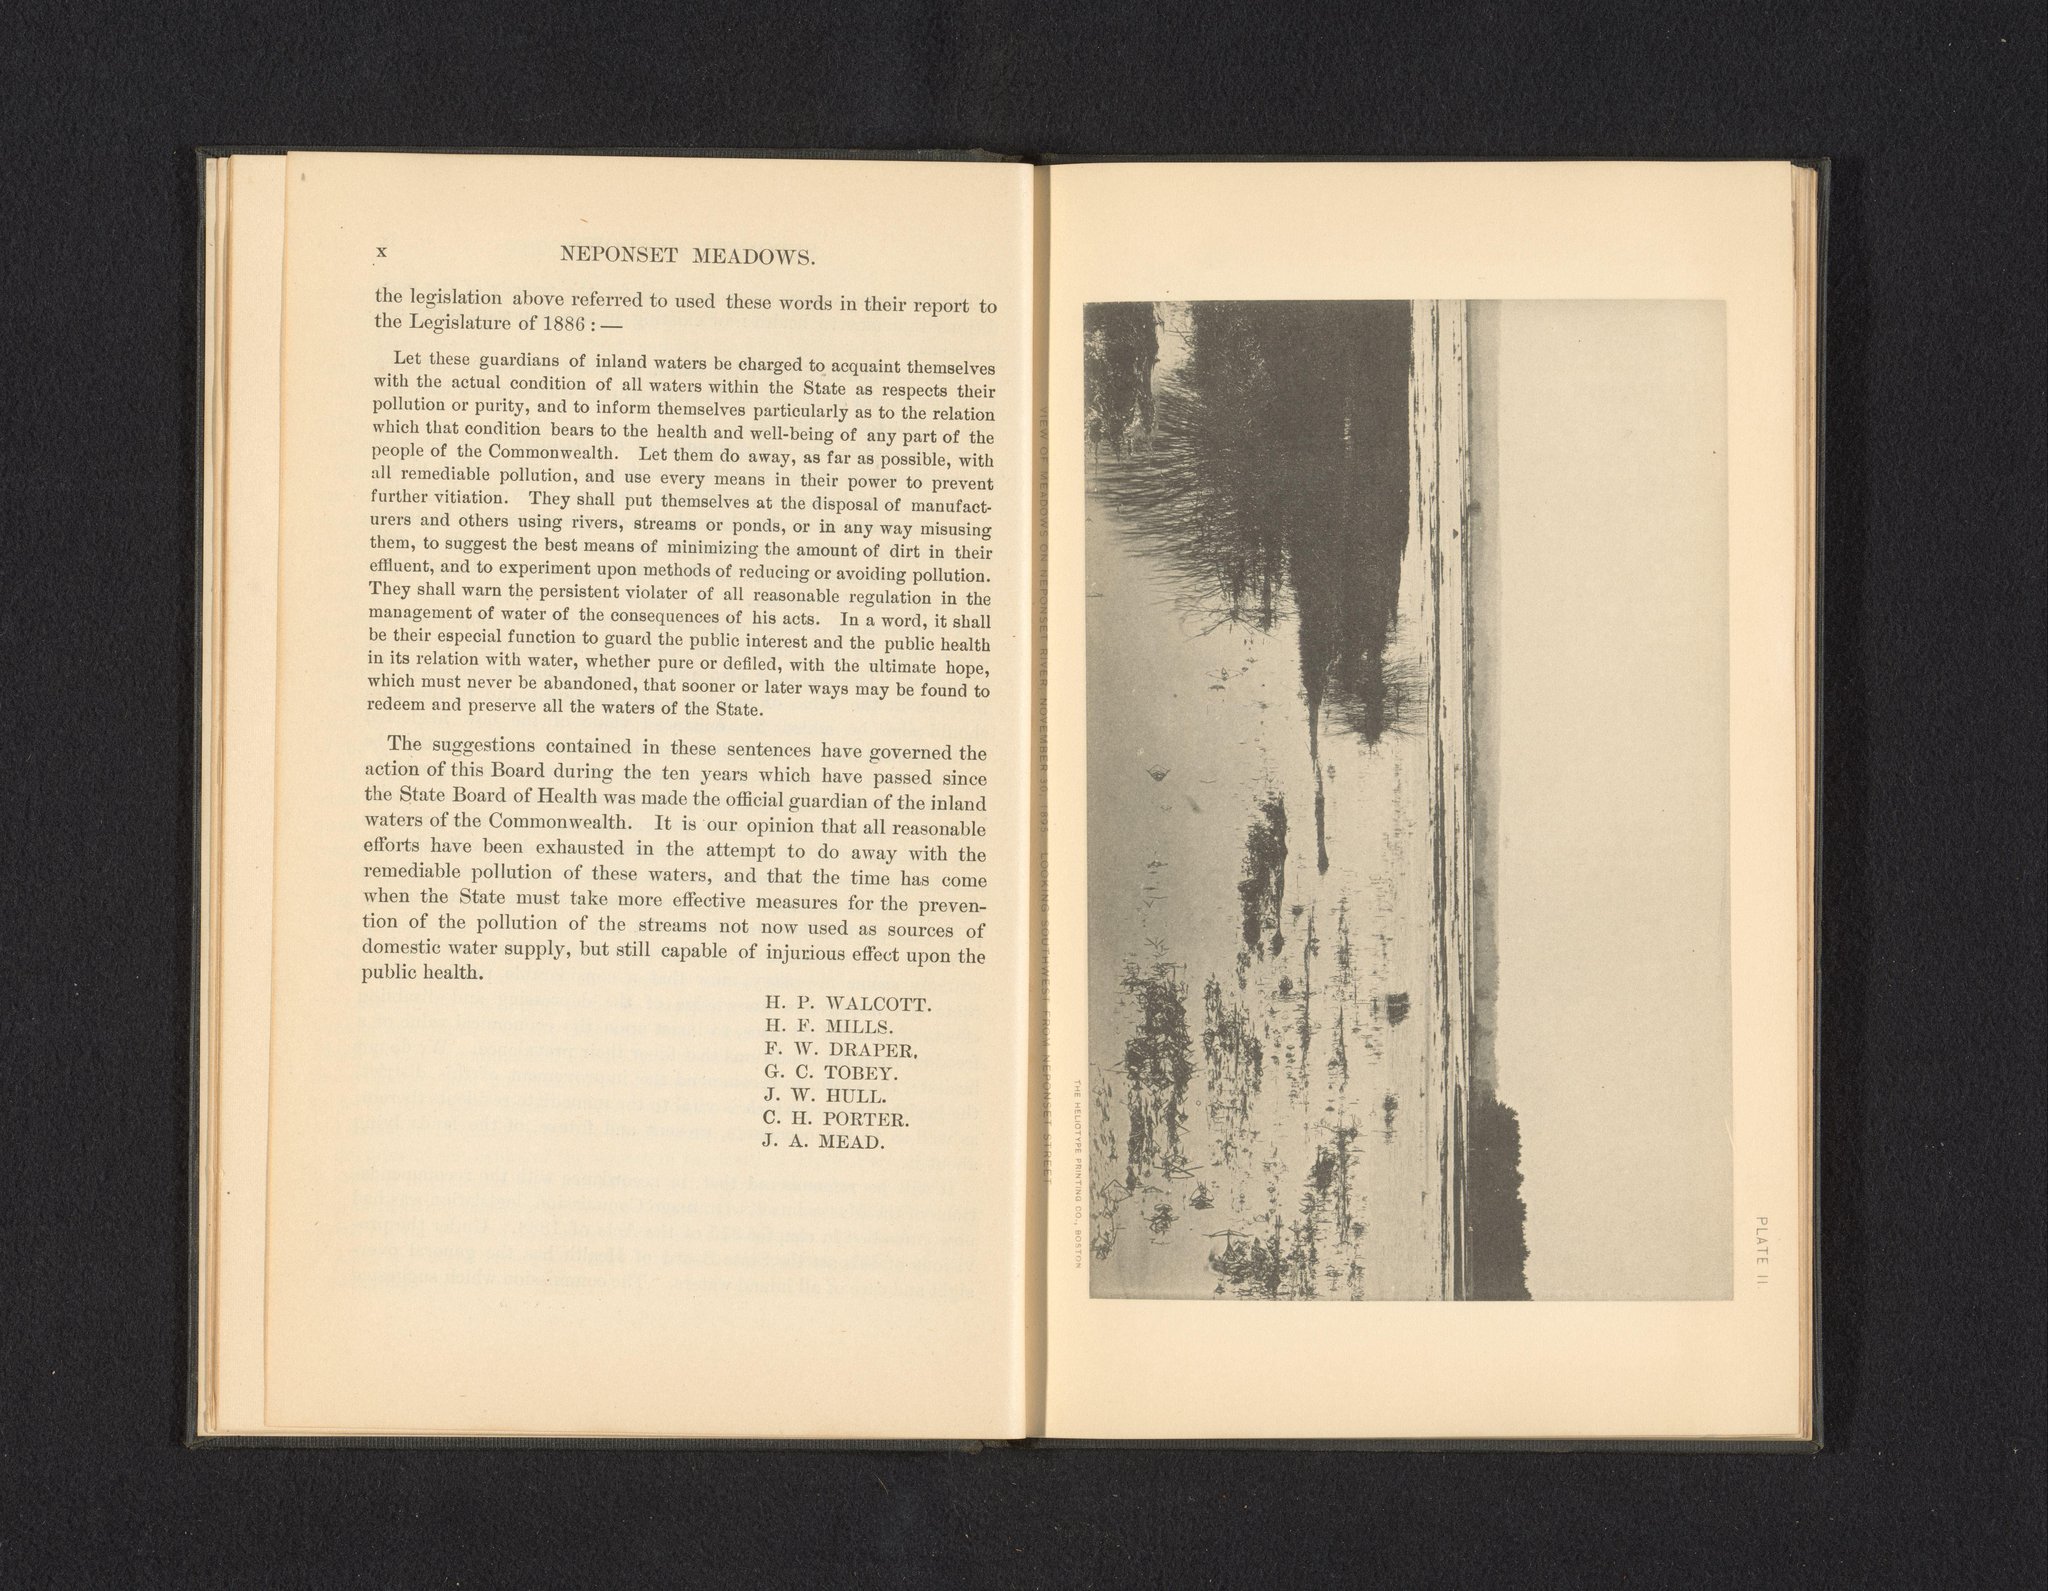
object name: photomechanical print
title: View of meadows on Neponset River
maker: Anonymous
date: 1895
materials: paper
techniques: photograph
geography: boston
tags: water meadows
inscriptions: number: ‘Plate II.’